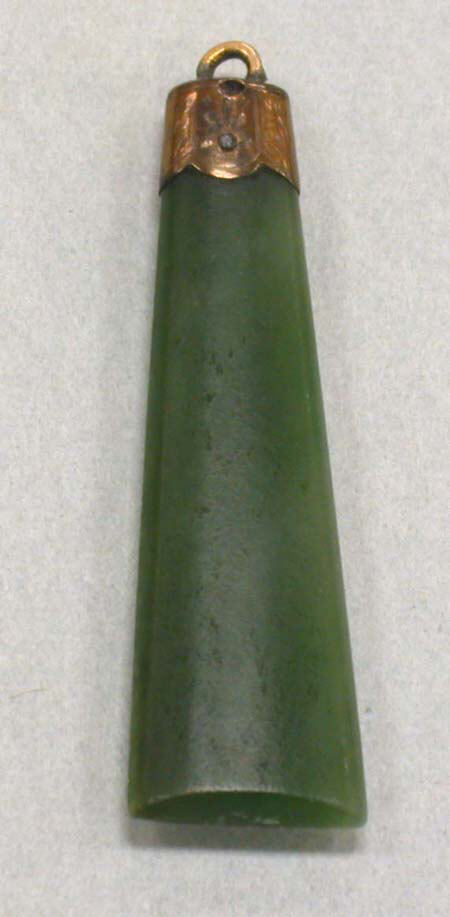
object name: pendant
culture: new zealander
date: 1801-1900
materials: jade